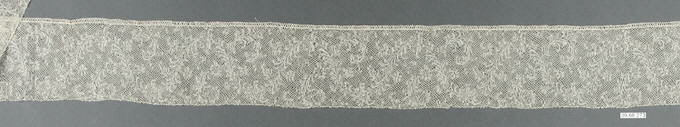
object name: strip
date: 1601-1800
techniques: lace